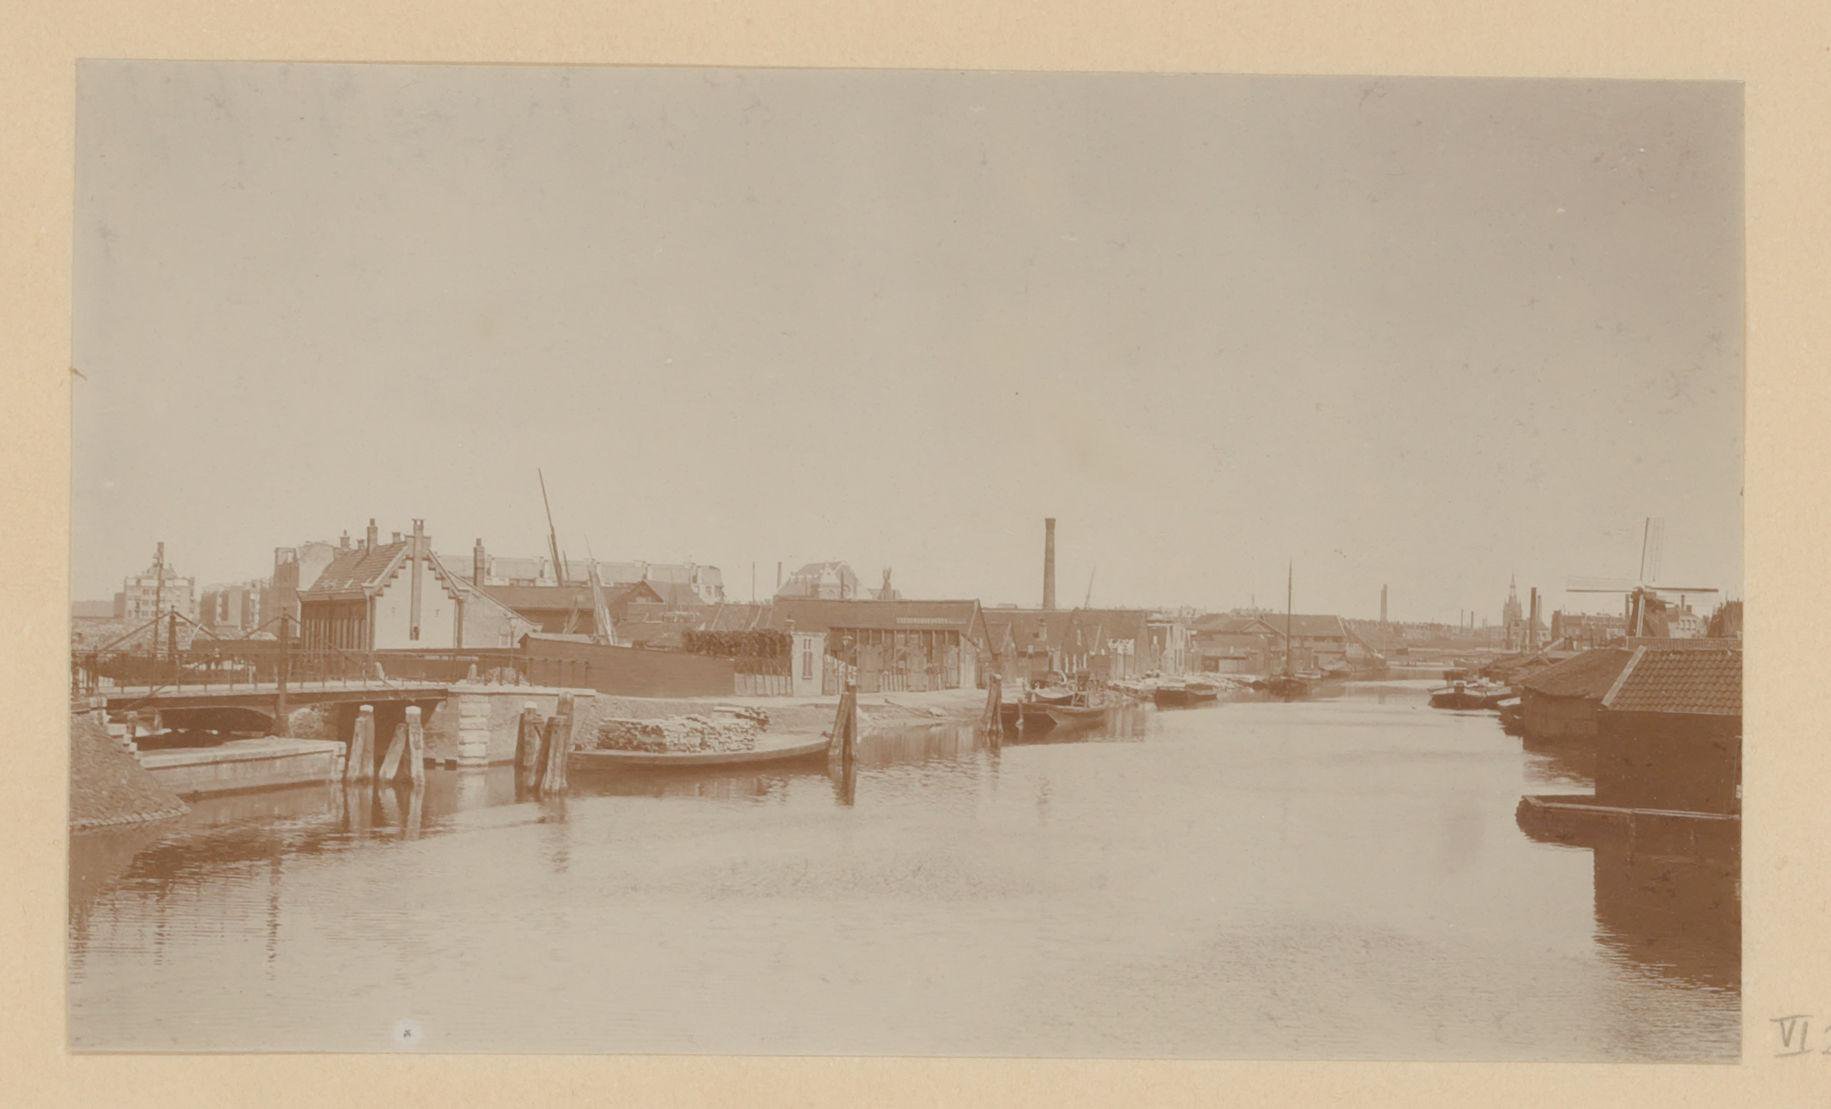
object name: photograph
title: Gezicht op de vuilnisbelt bij de Buyskade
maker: Anonymous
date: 1917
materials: paper, cardboard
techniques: gelatin silver print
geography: amsterdam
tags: city-view in general; 'veduta', canal, garbage collection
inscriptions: collector's mark: ‘6’ Lugt 1641b, inscription: ‘Buyskade / Kostverlorenvaart / [...]5 / vuilnisbelt in 1917. / April 1920. / Geschenk v/d Heer J. van Eck.’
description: Onderwerpsrubriek binnen de Atlas Amsterdam: Buijskade, Catskade (Jacob), Clercqstraat (de), Commelinstraat, Costakade (da), Cuypstraat (Albert), Czaar Peterstraat.